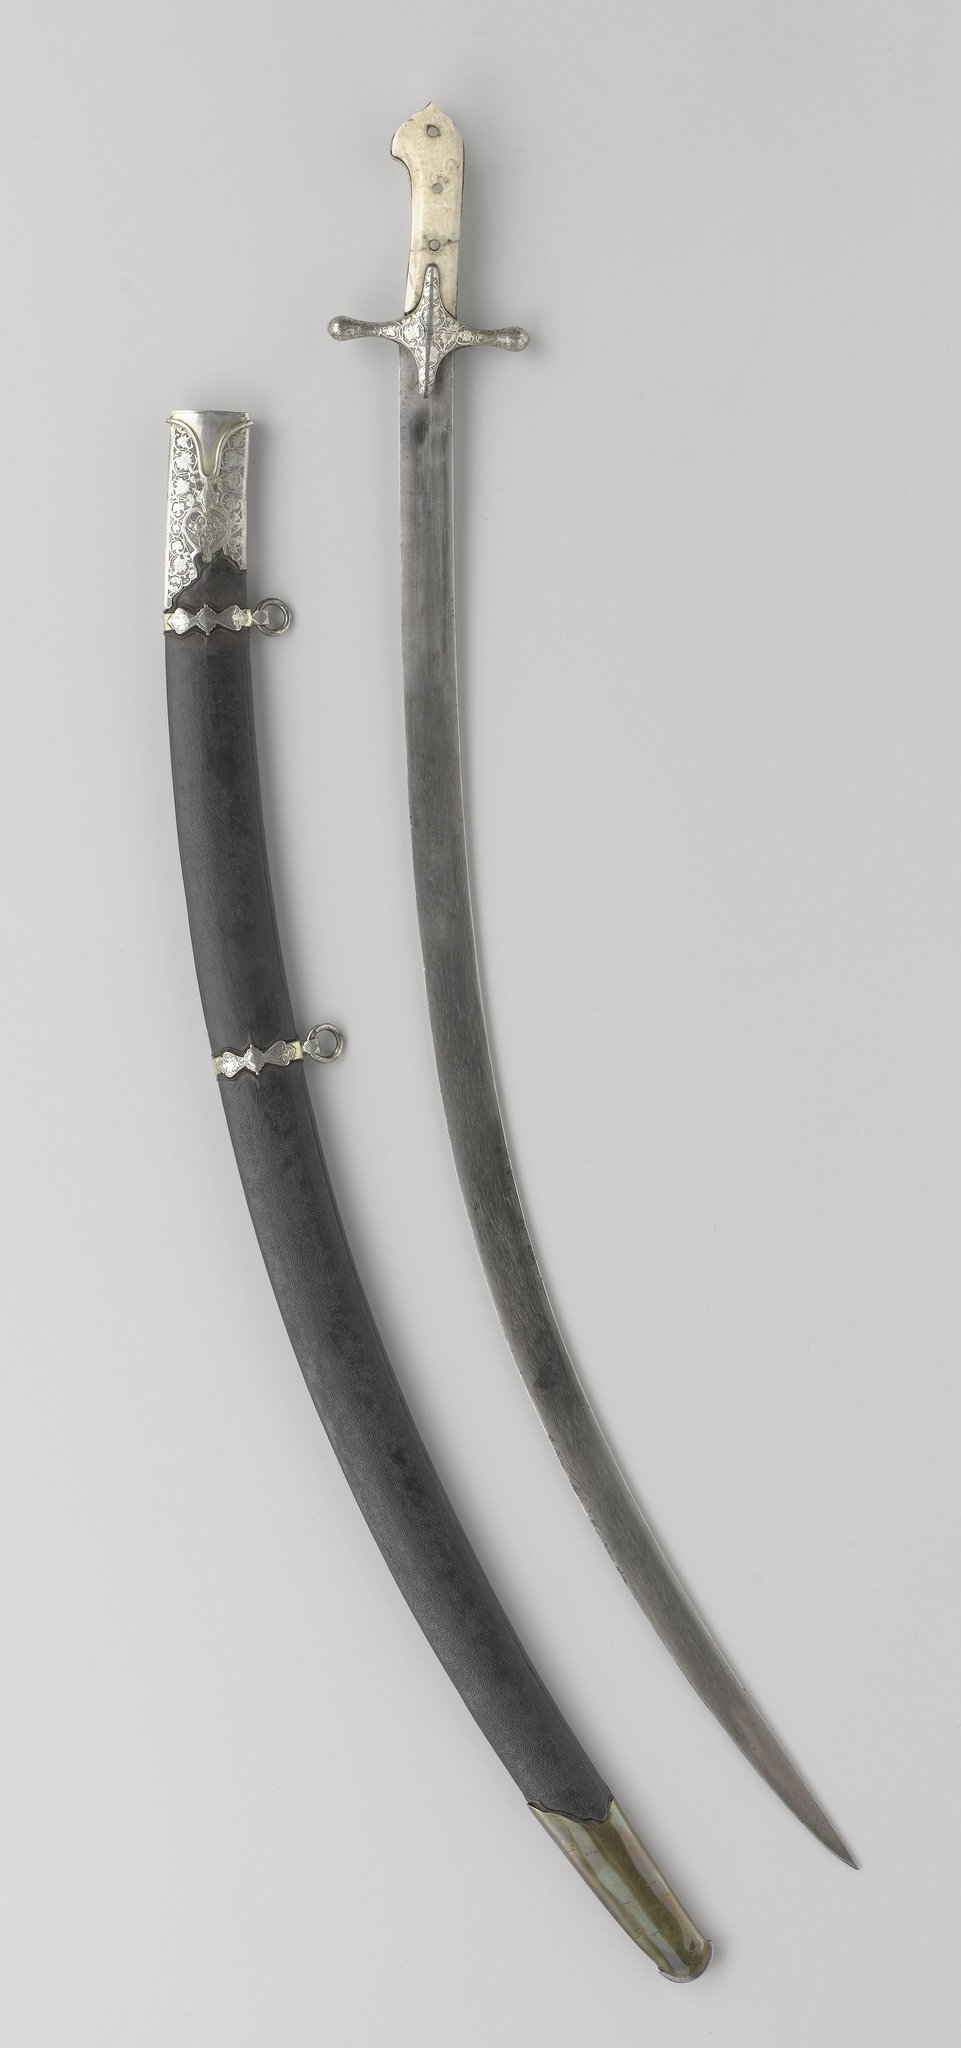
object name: sabre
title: Persian sabre of Cornelis Tromp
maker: Anonymous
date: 1600-1700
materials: copper, iron, ivory, leather, silver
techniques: repoussé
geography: iran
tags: rotterdam, amsterdam, cornelis tromp, ornament derived from plant forms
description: This Persian sabre must have had a special significance for Cornelis Tromp, for he had himself immortalized in Roman dress with the weapon in a painting by Abraham Willaerts (in the centre of this display case). Such references to Classical antiquity were extremely common in this period.